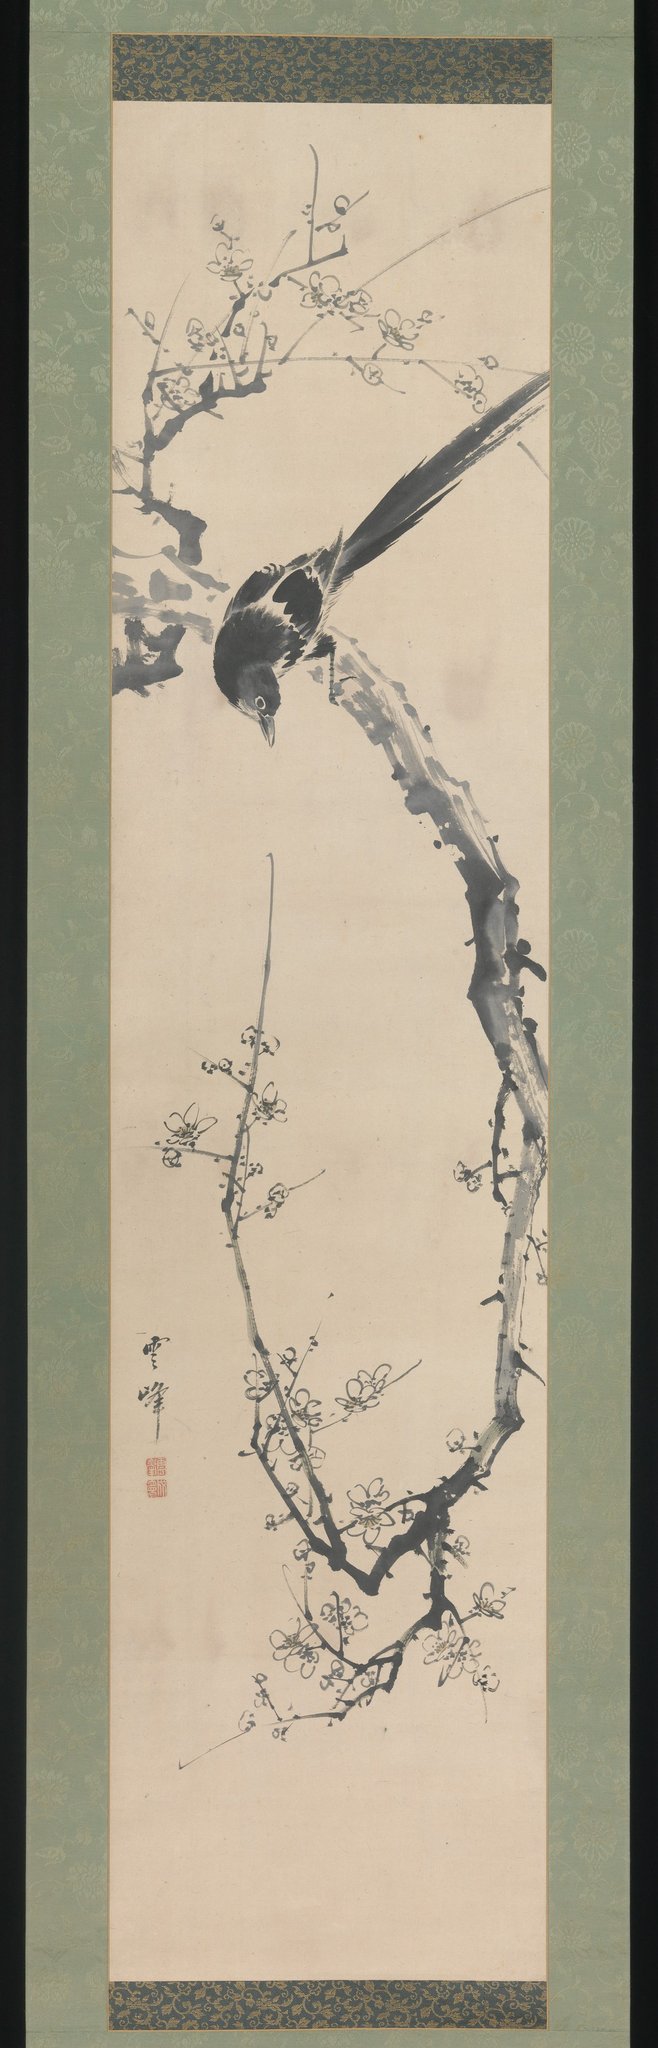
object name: hanging scroll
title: Bird and Plum Blossoms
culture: japanese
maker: unpō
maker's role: artist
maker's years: 1765-1848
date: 1701-1900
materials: ink, paper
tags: birds,flowers